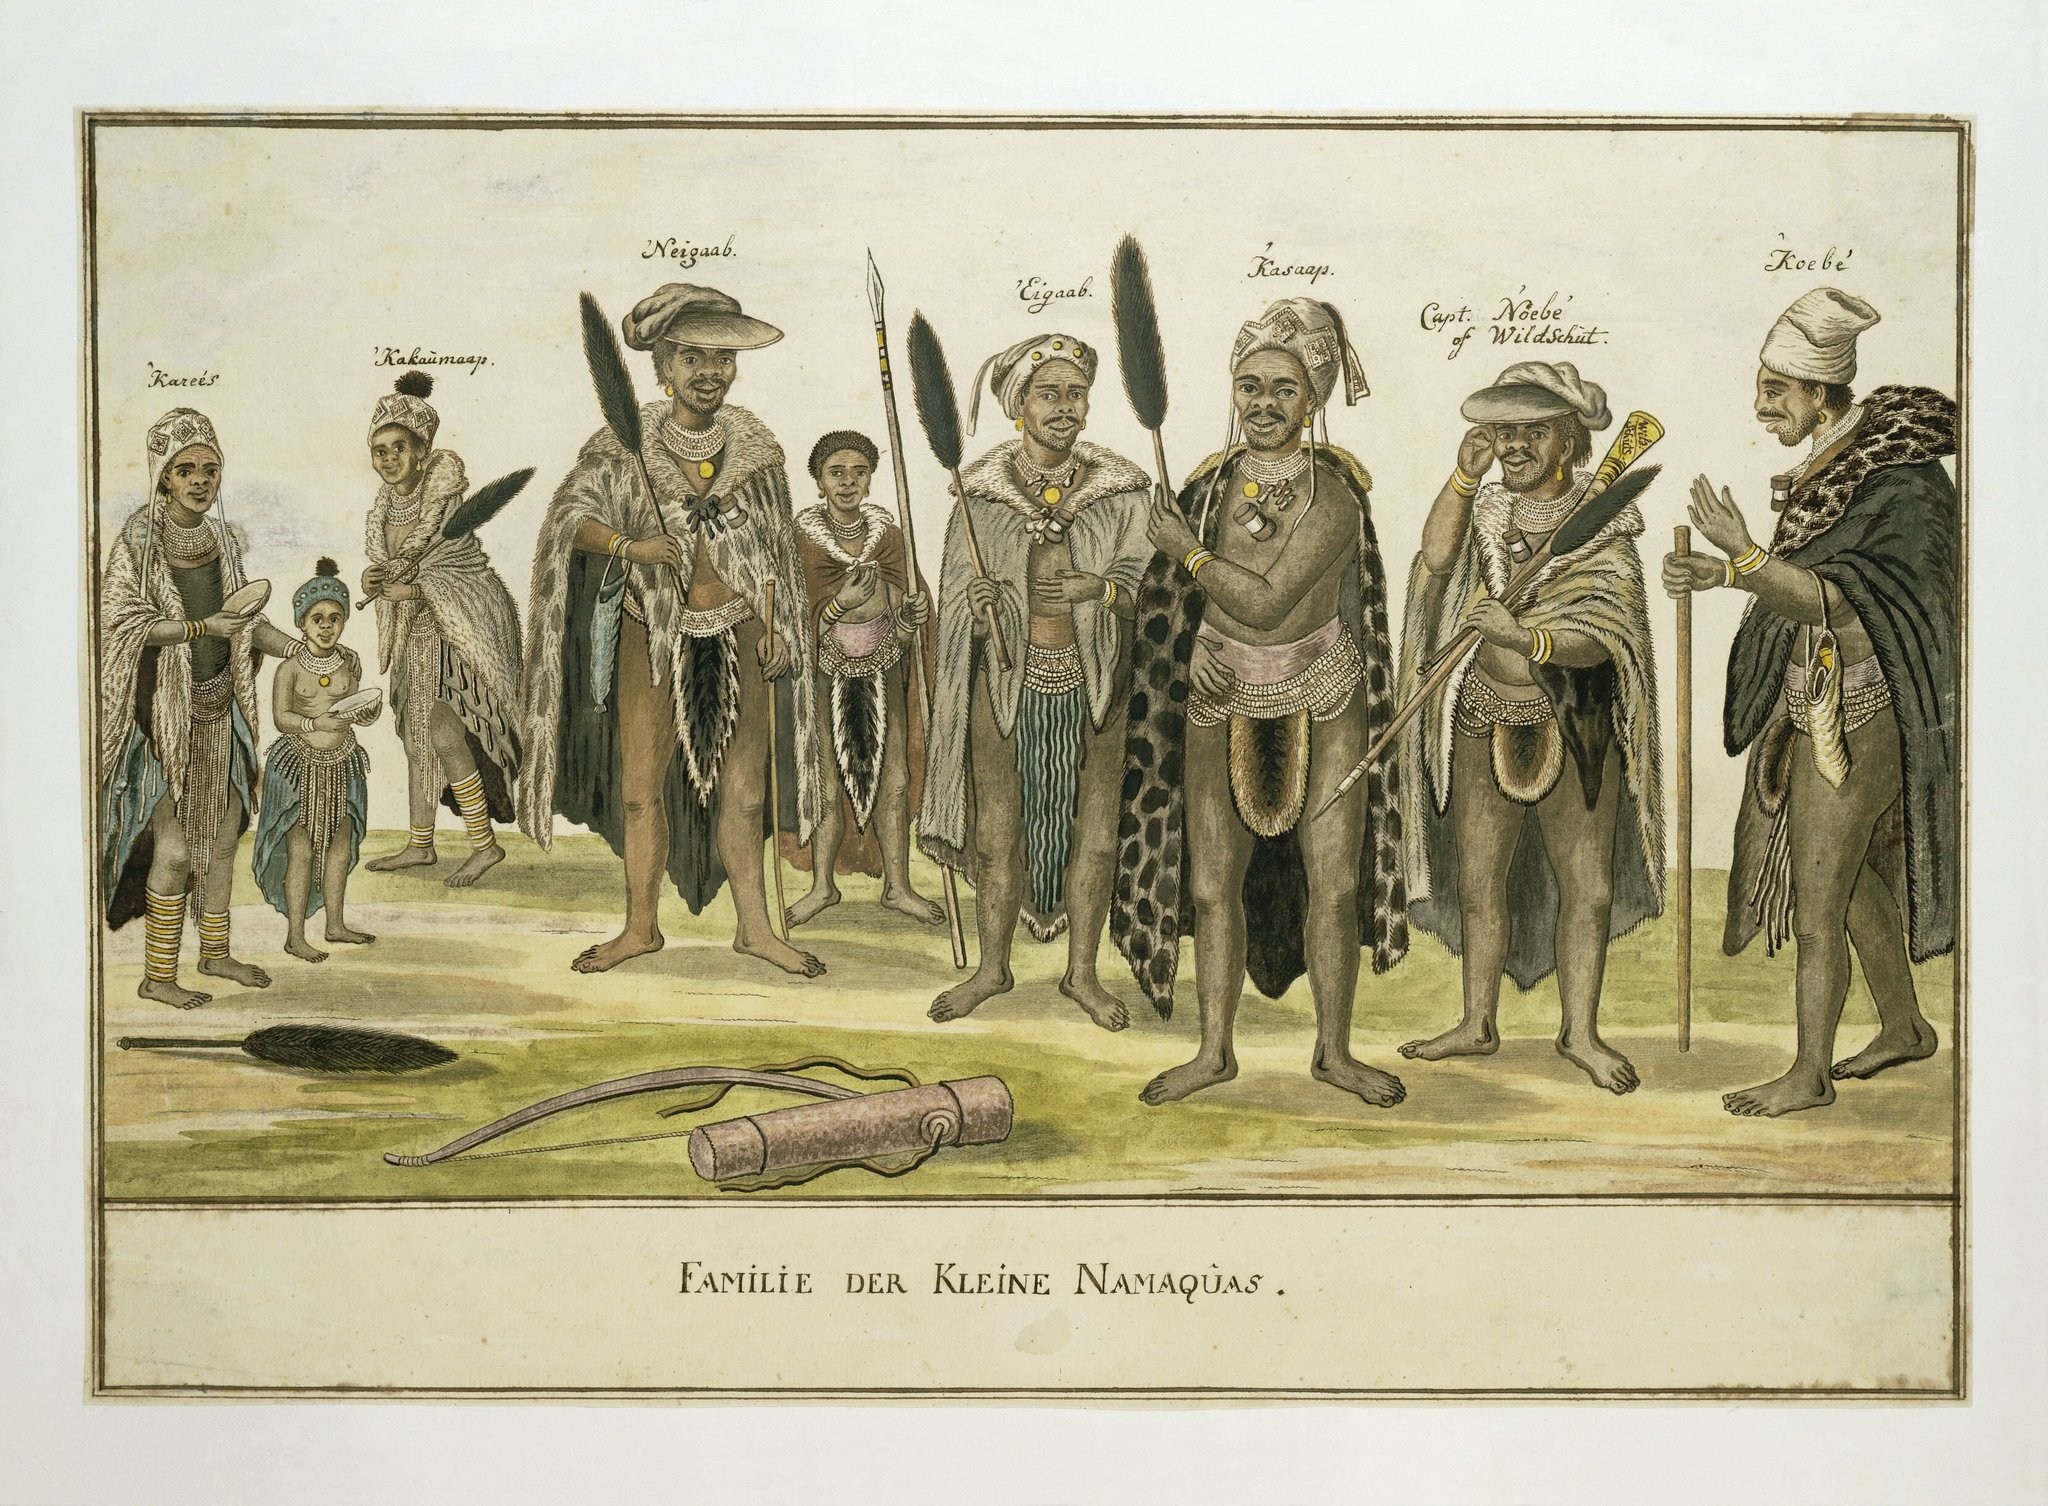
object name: album leaf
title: Chieftans of the Namaqualand region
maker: robert jacob gordon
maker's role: draughtsman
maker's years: 1743-1795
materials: chalk, paint, ink, paper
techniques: brush, pen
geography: cape province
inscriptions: annotation: ‘Familie der Kleine Namaqûas (onderaan)’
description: Khoi ‘familie der kleine Namaquas’ Een van de afgebeelde Khoi is het opperhoofd Noebe of Wildschut met zijn door de VOC geschonken waardigheidsstaf.